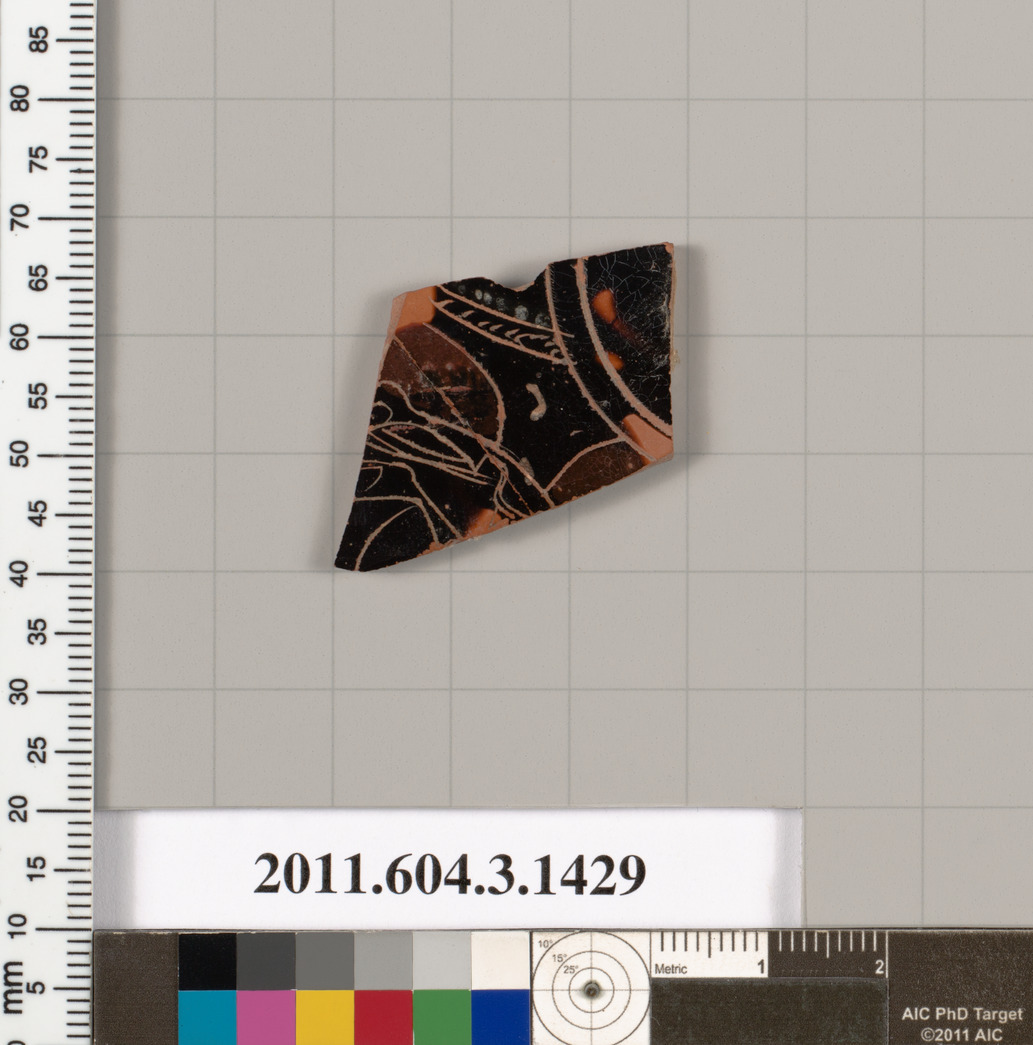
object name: skyphos fragment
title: Terracotta fragment of a skyphos (deep drinking cup)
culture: greek, attic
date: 550-501 BCE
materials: terracotta